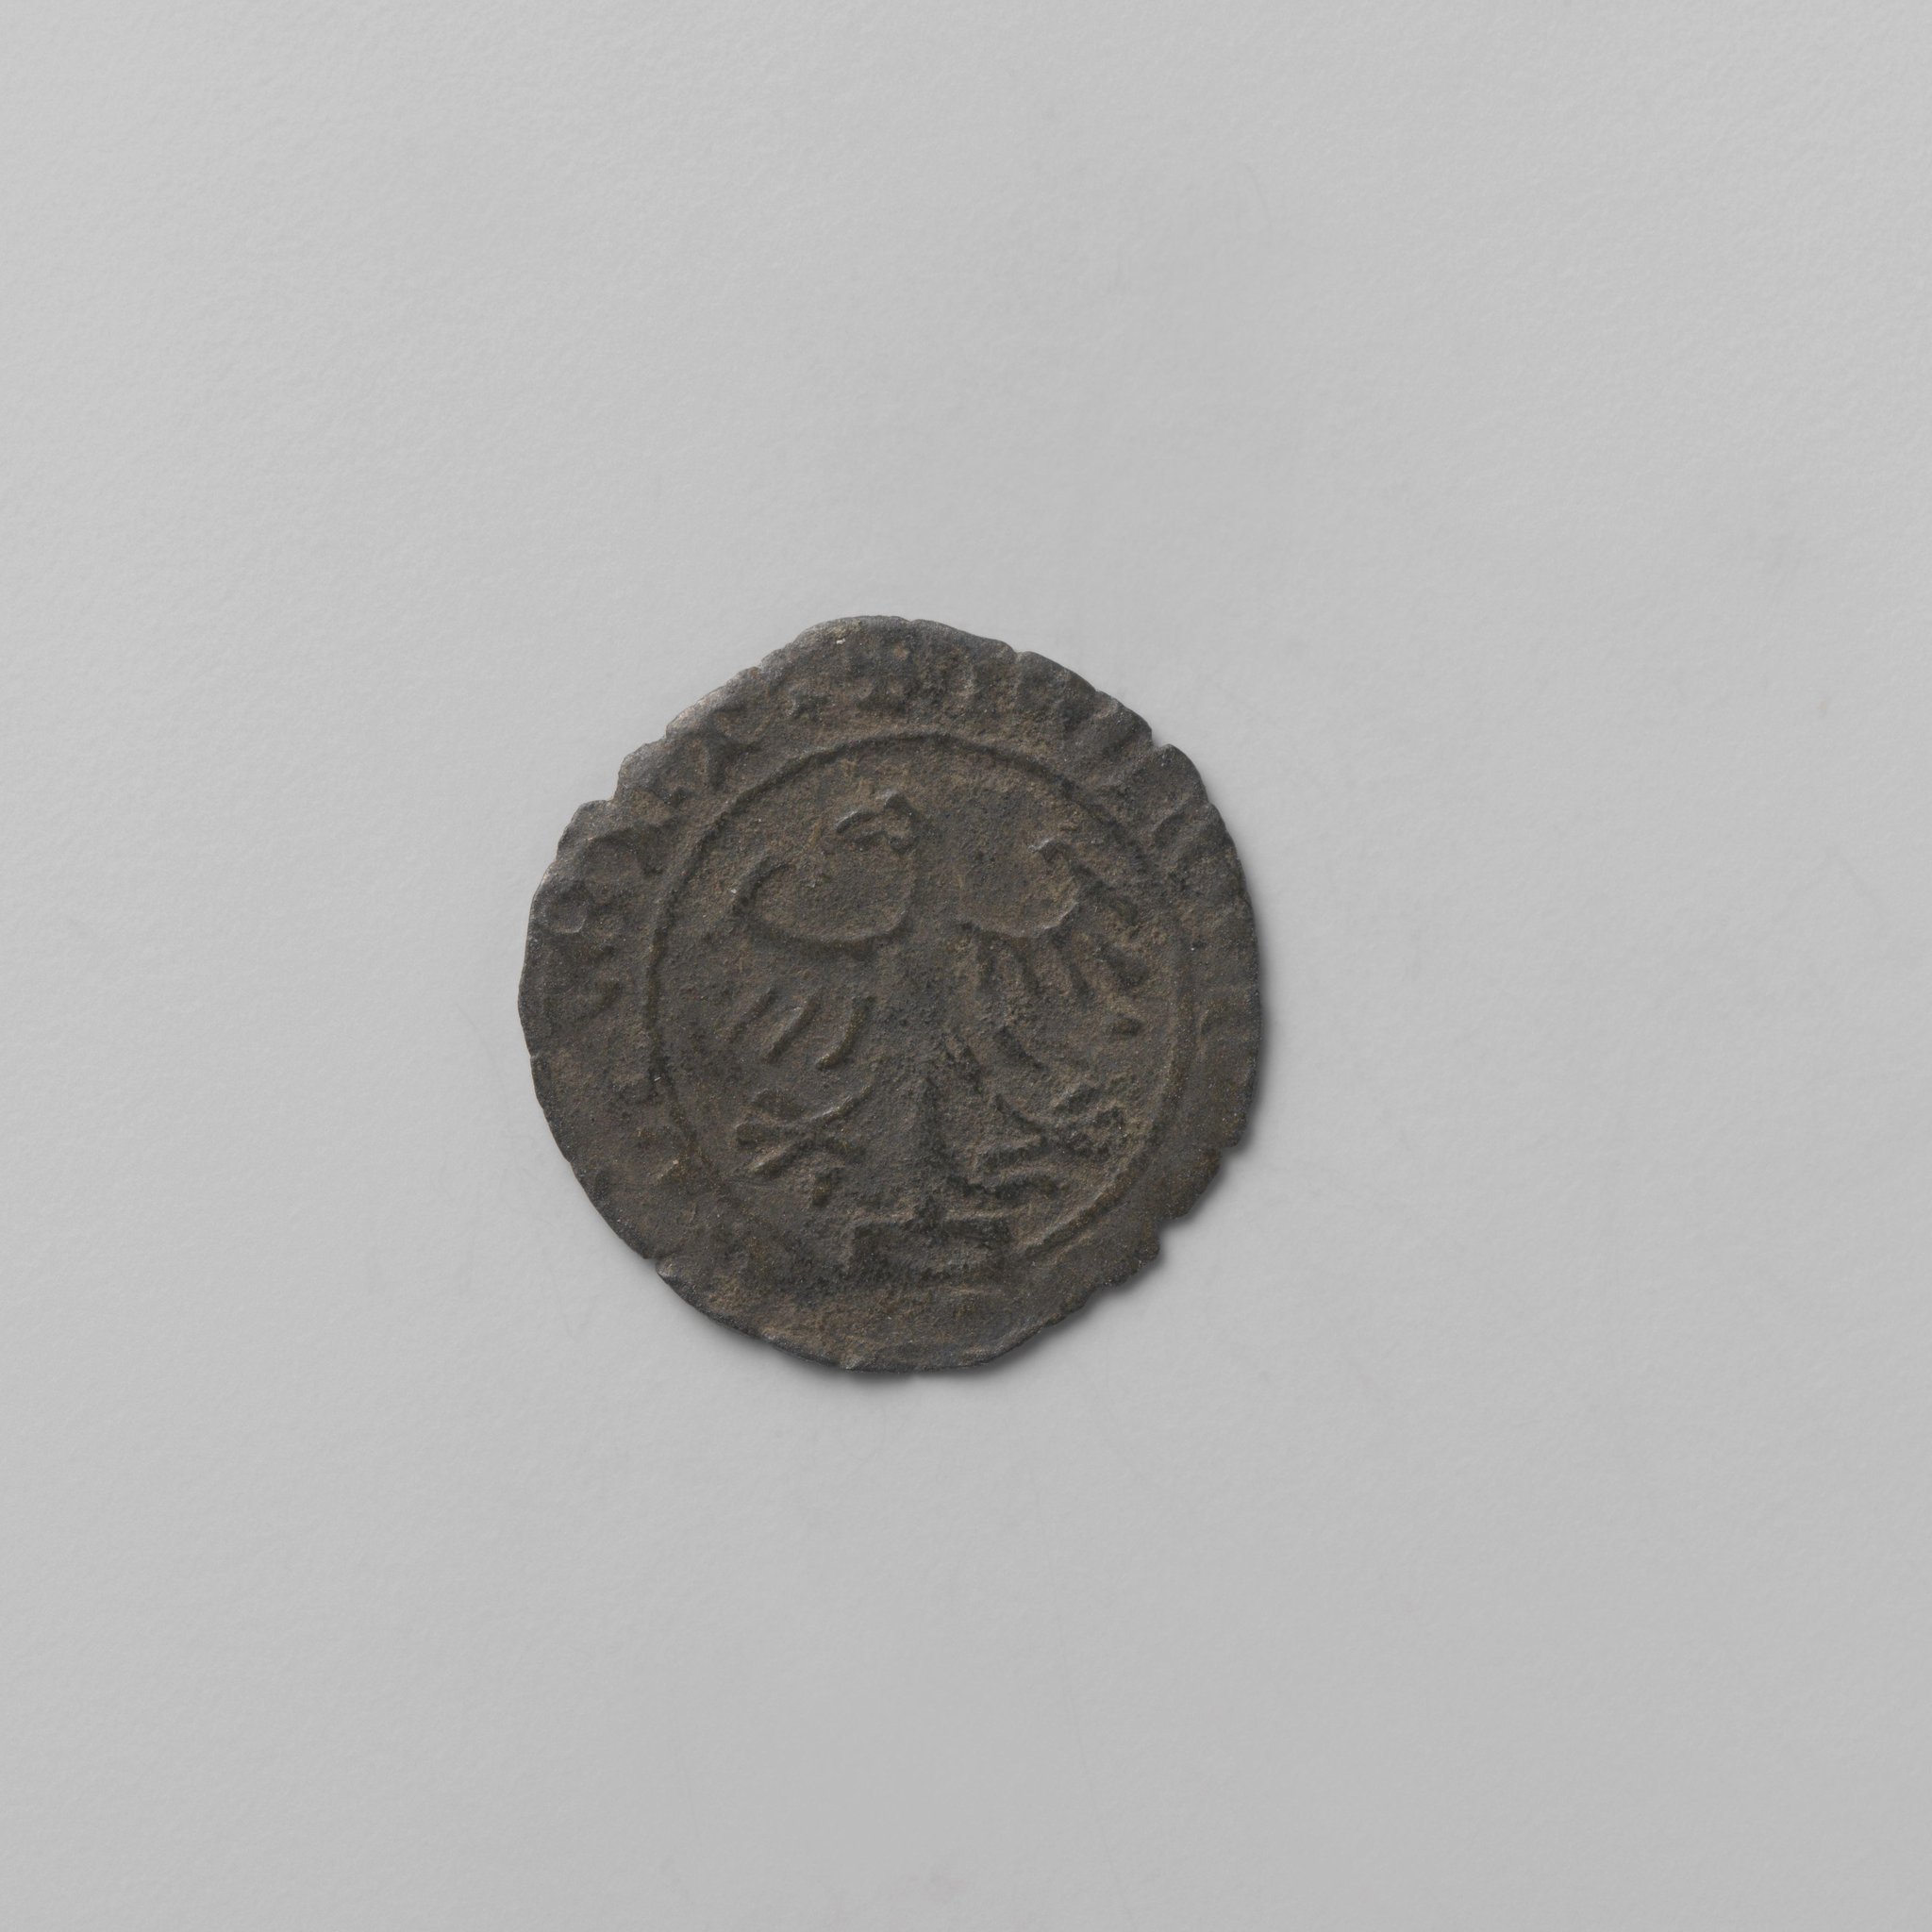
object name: coin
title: Deventer, halve plak, 1476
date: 1476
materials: silver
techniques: striking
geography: deventer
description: Zilveren munt. Voorzijde: eenkoppige adelaar met onder zijn poten wapenschild. Keerzijde: kort gevoet kruis.